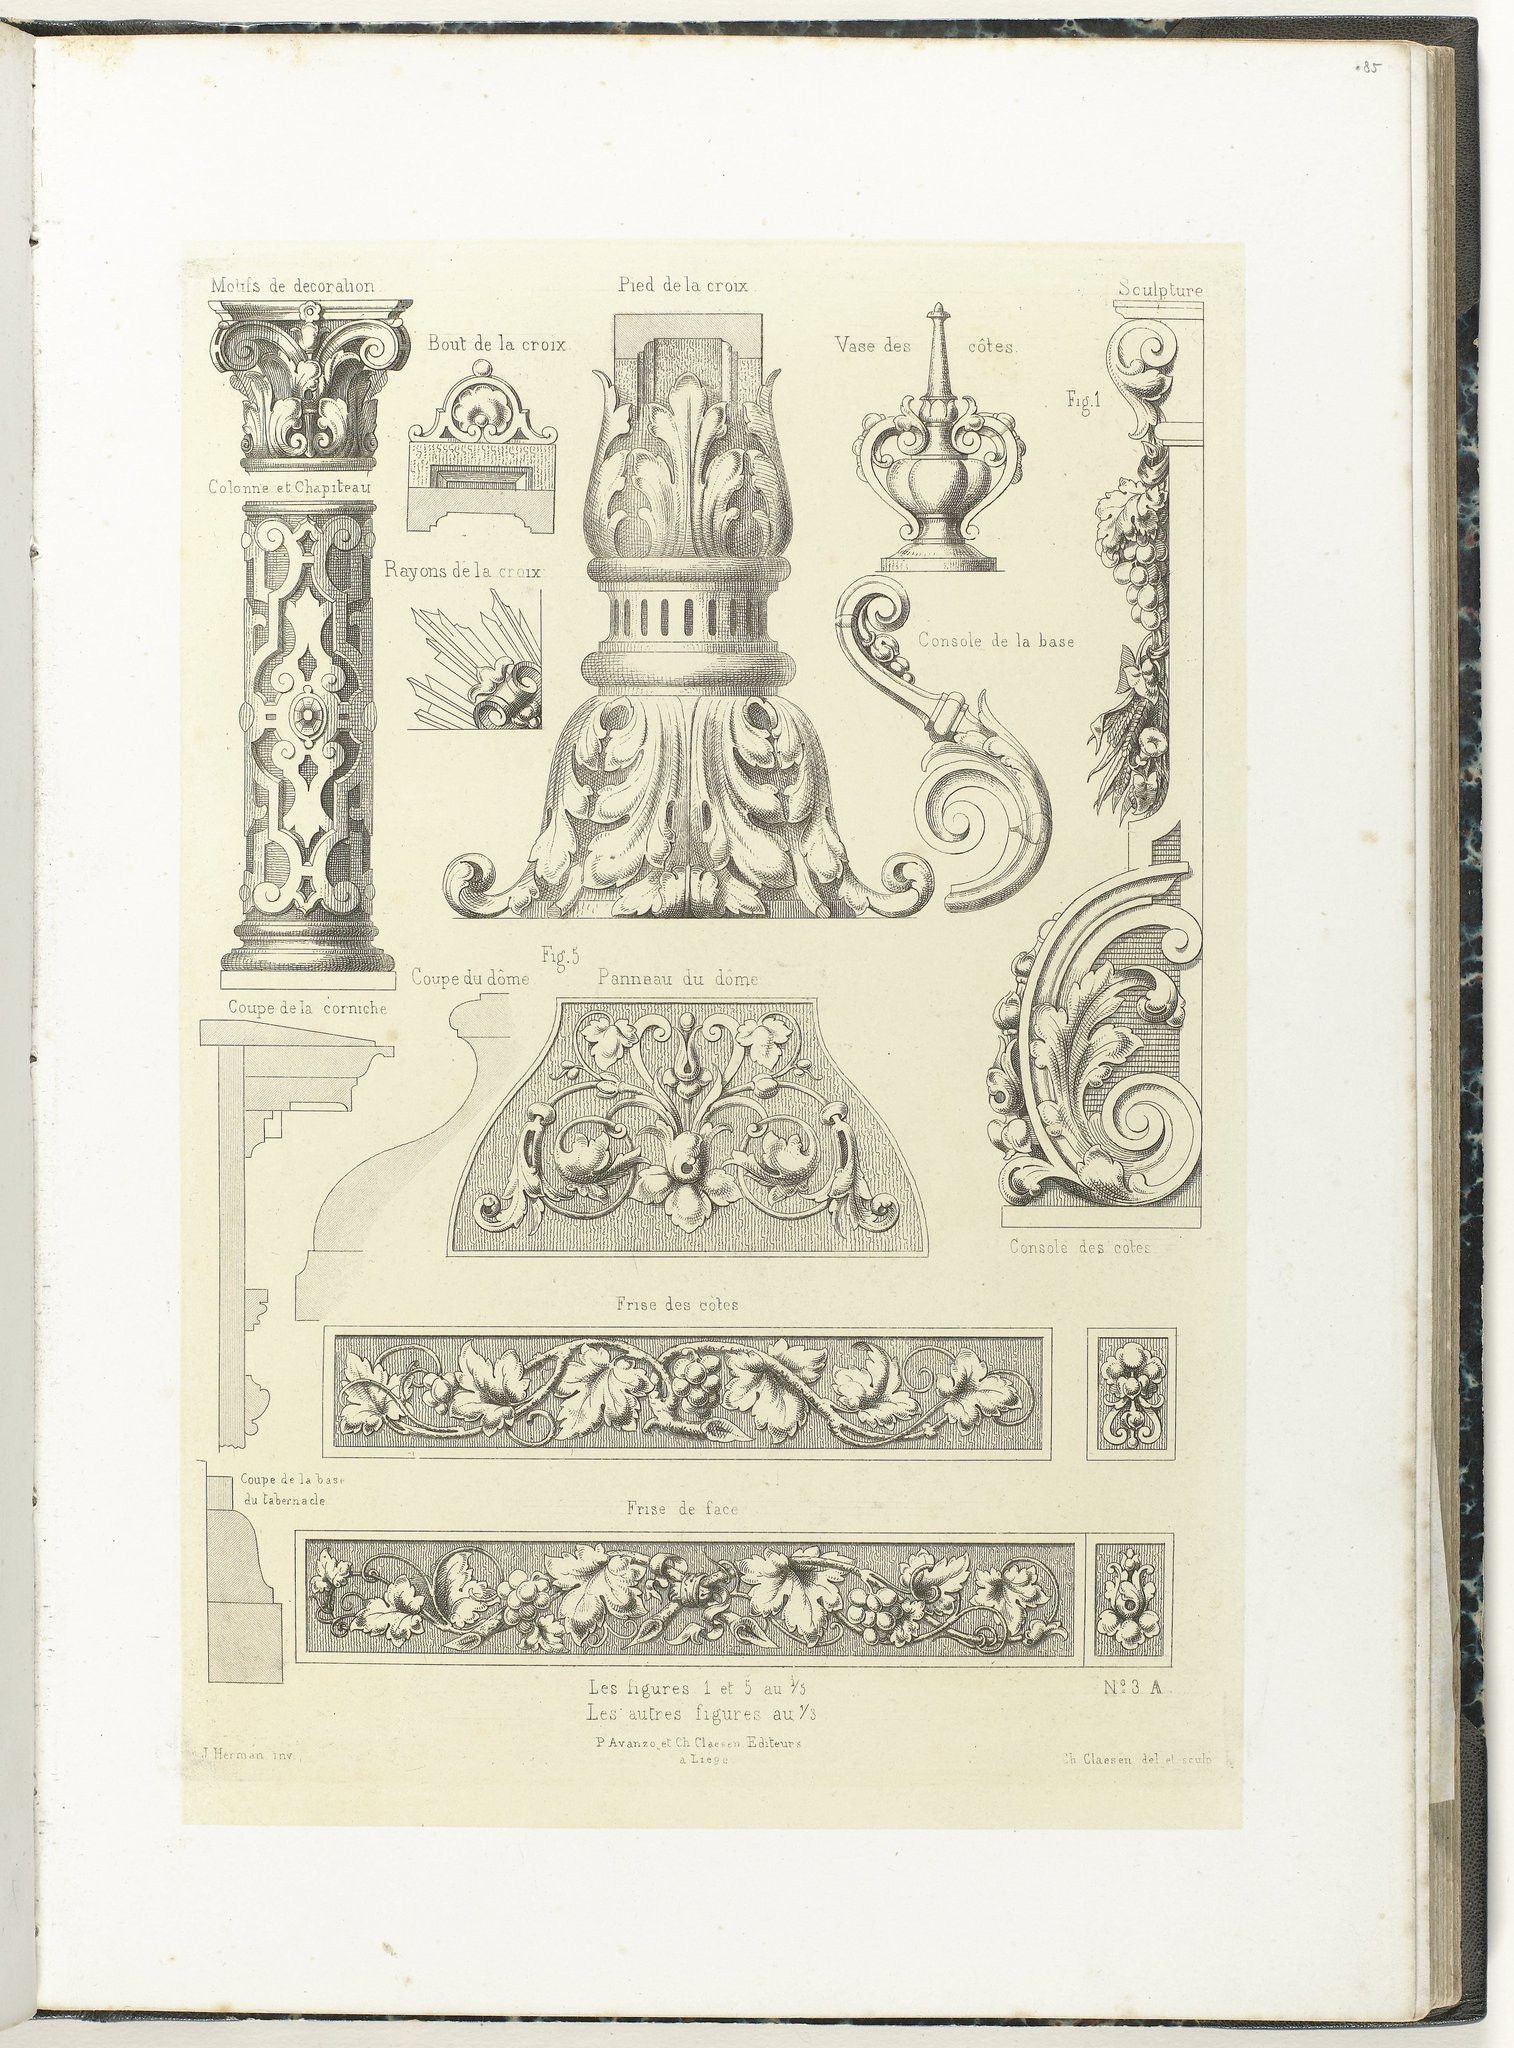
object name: print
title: Dertien bouwkundige ornamenten en drie doorsneden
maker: j. herman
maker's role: designer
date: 1866-1900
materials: paper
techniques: tone lithography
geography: liège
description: Linksboven staan een zuil en een kapiteel afgebeeld. Daarboven staat vermeld: Motifs de decoration, rechtsboven: Sculpture, rechtsonder: N° 3 A